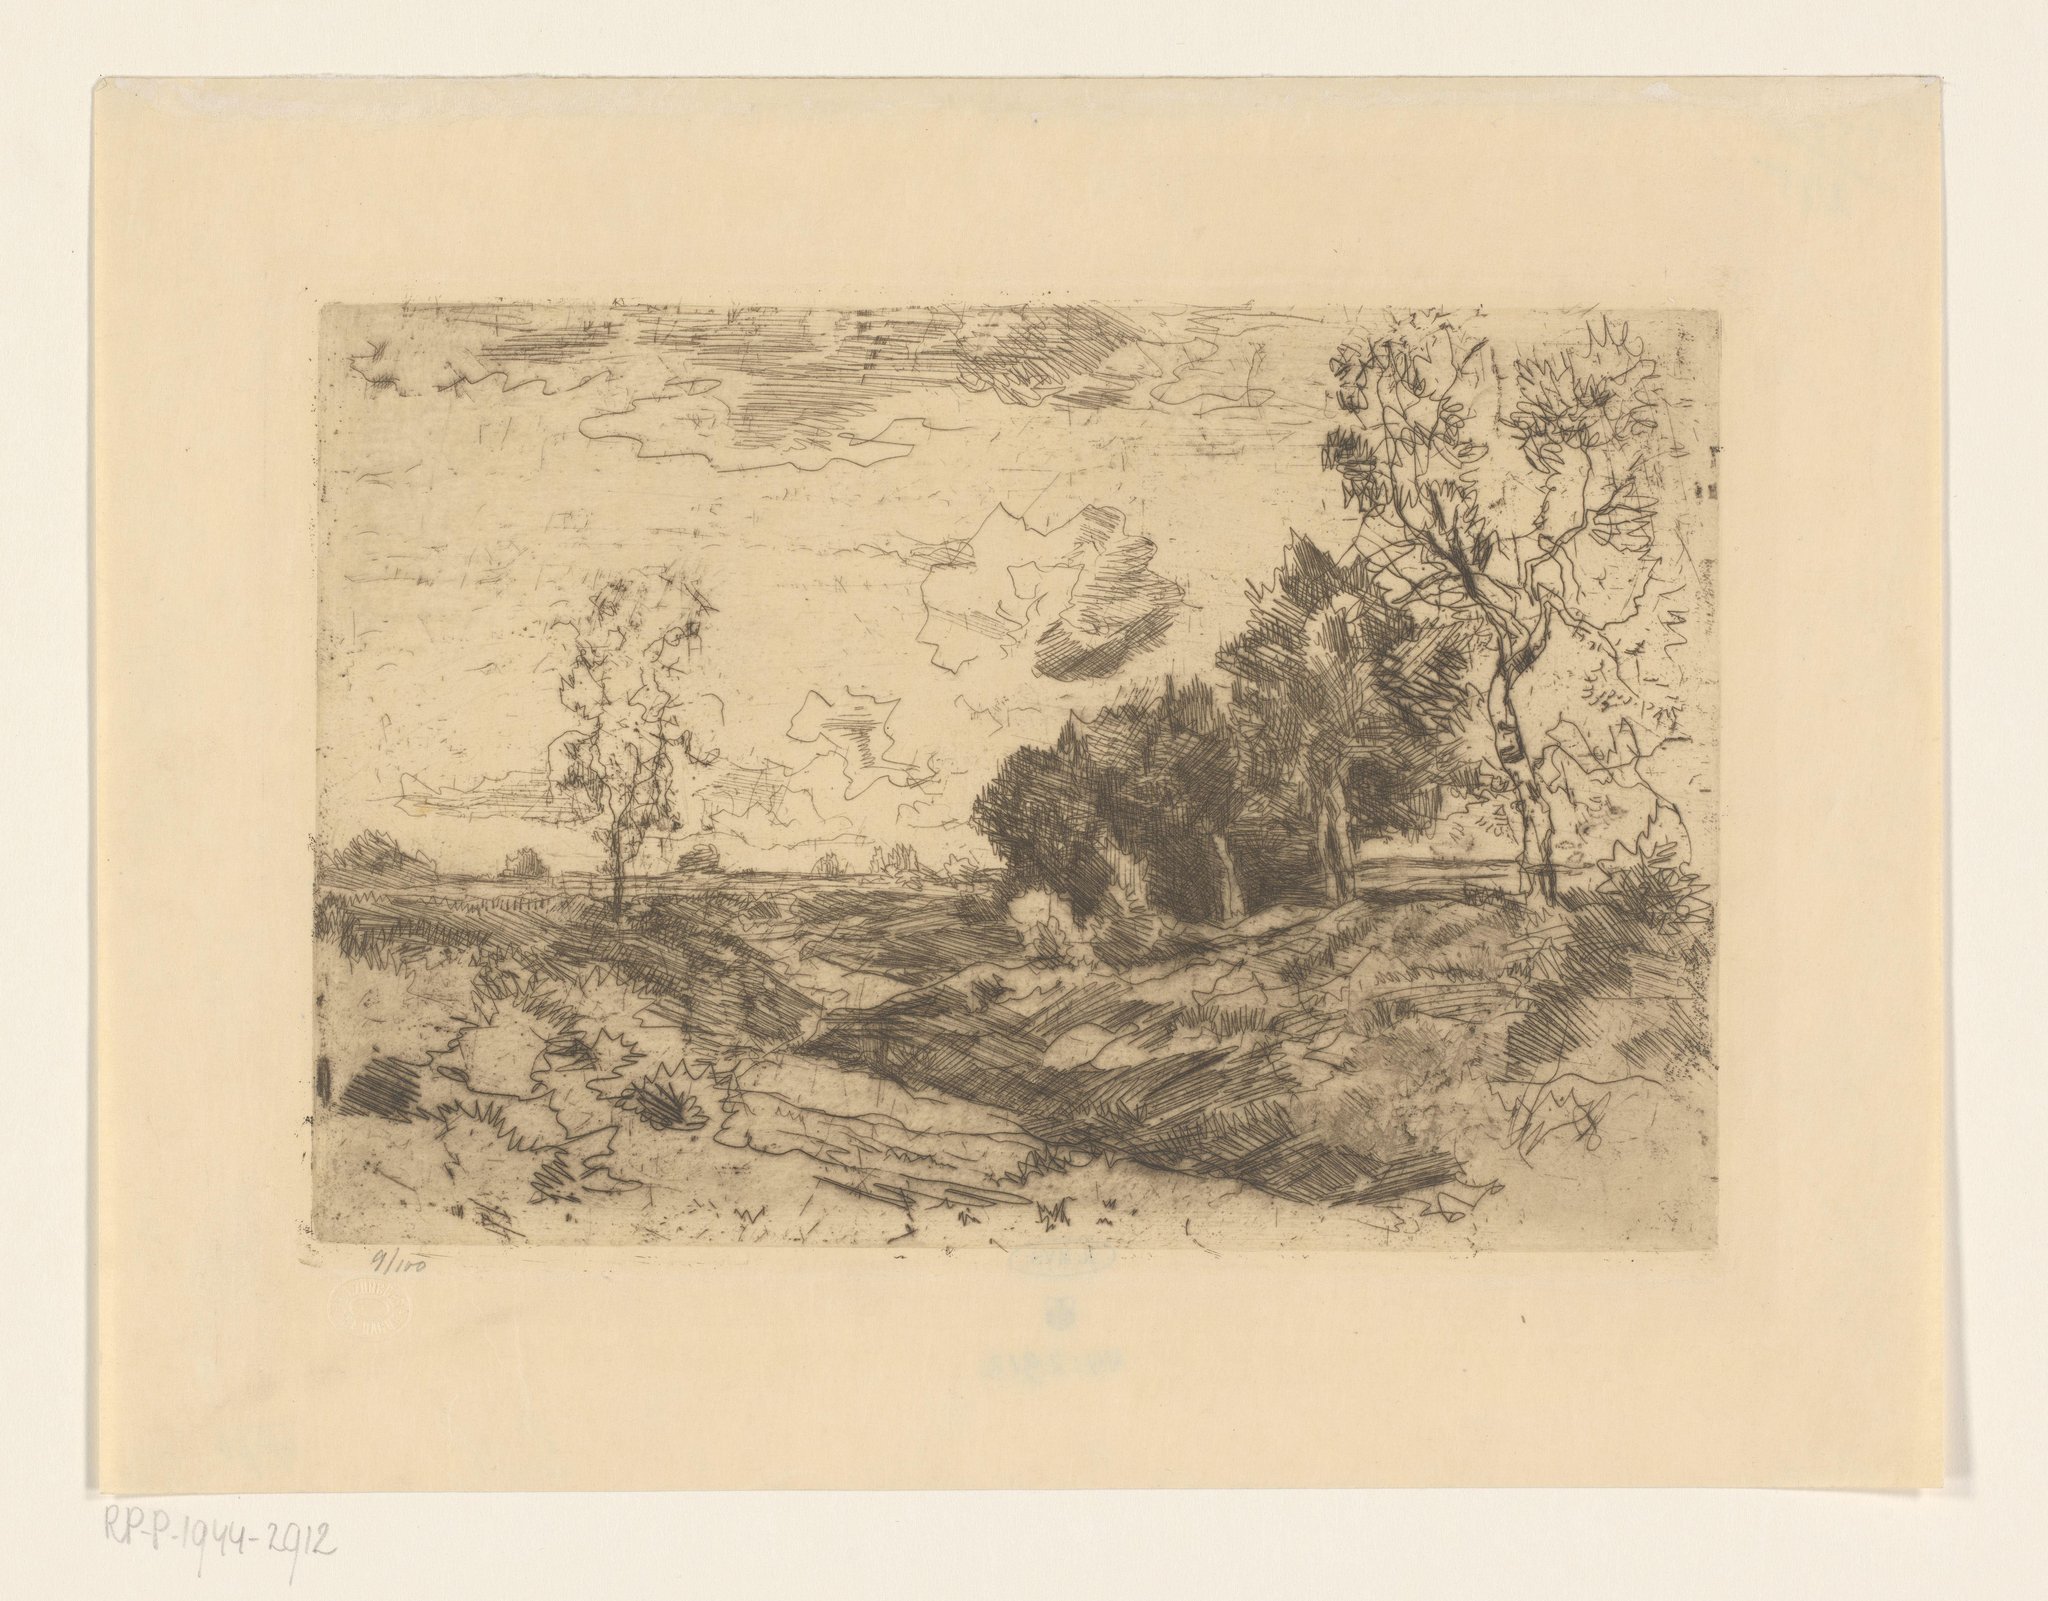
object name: print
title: Landschap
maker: théophile de bock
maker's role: draughtsman, painter, print maker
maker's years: 1851-1904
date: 1861-1904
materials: paper, ink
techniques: drypoint, etching, intaglio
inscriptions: edition: ‘9/100’, collector's mark: Lugt 2760, collector's mark: Lugt 2228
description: Landschap met rechts een bomengroep, schetsmatig weergegeven.